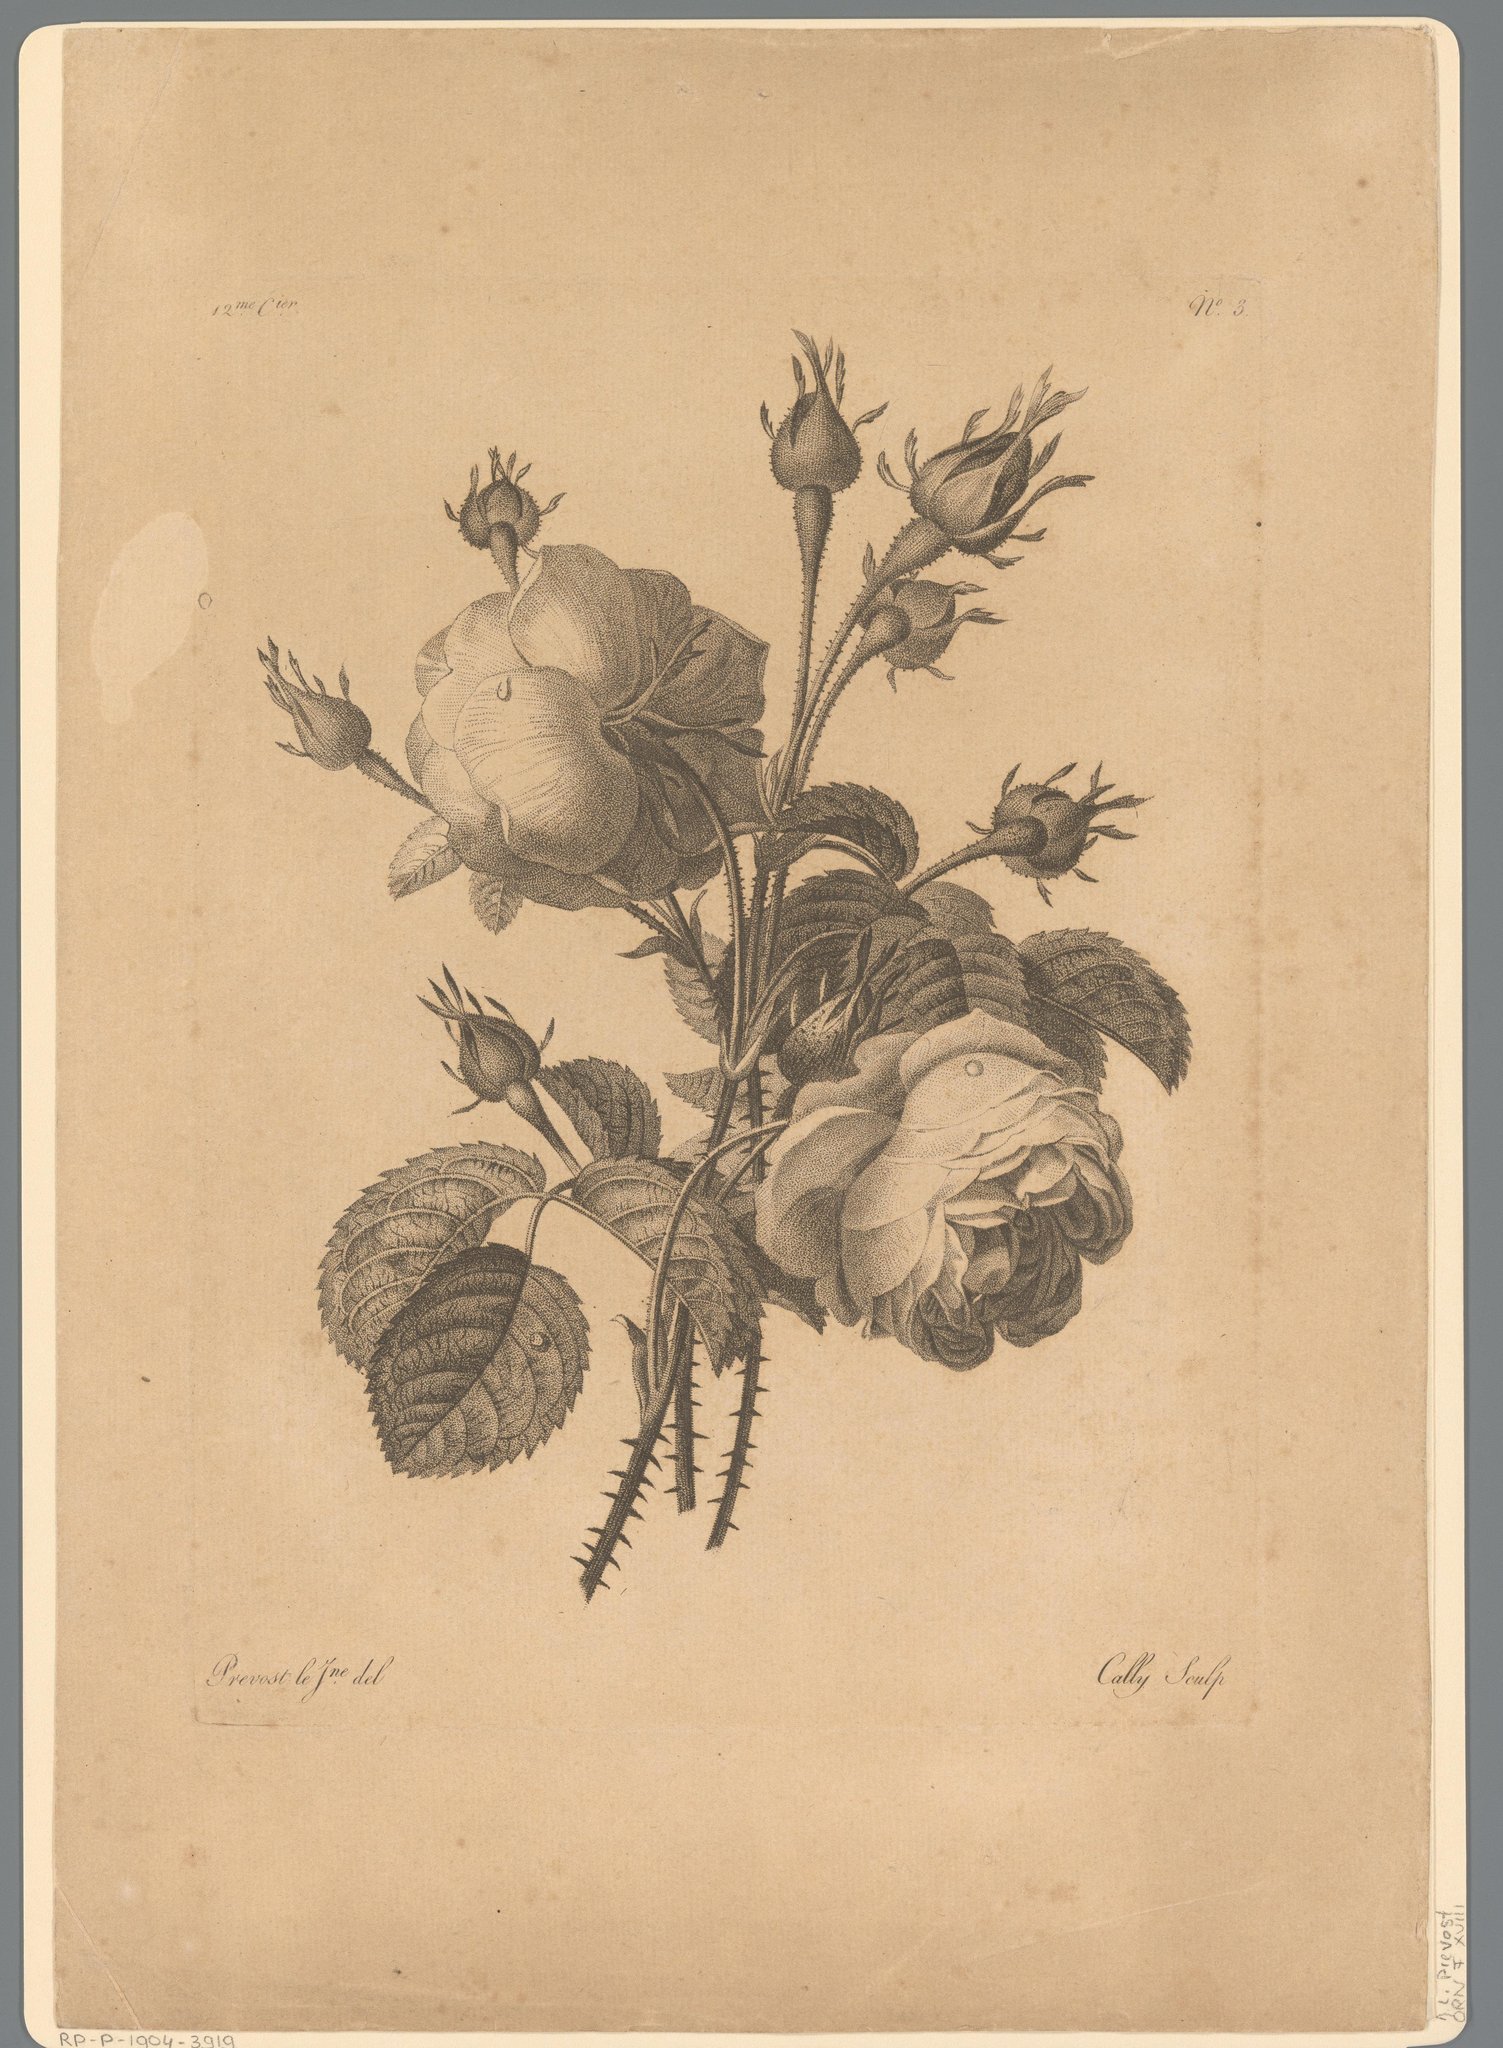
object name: print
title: 12me Cahier de Fleurs et de Fruits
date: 1770-1810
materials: paper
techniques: engraving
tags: flowers: rose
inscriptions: collector's mark: Lugt 2228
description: Drie rozentakken met bloemen en knoppen.